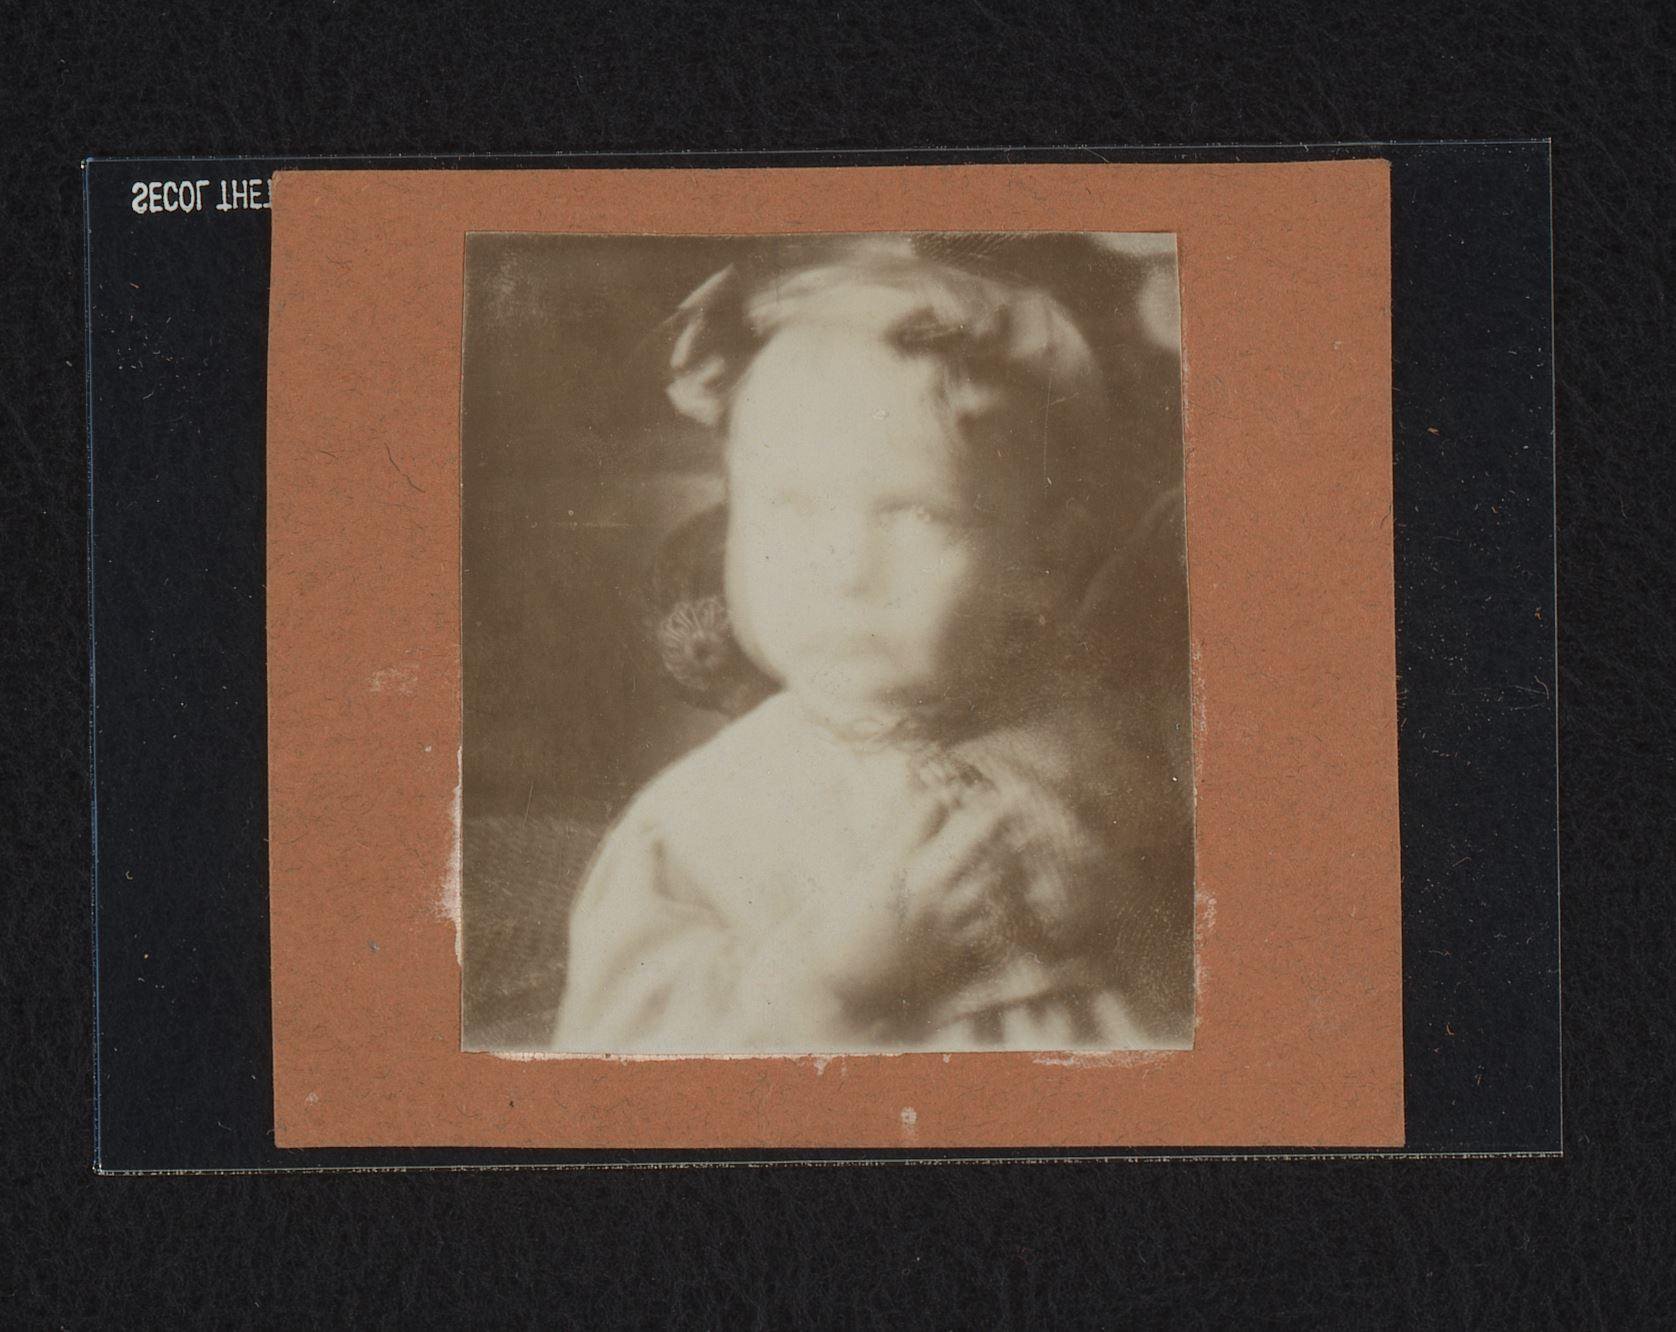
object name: photograph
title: Portret van een meisje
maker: Anonymous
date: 1880-1920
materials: cardboard, photographic support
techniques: collodion silver print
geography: germany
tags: historical persons - bb - woman, toddler (female)